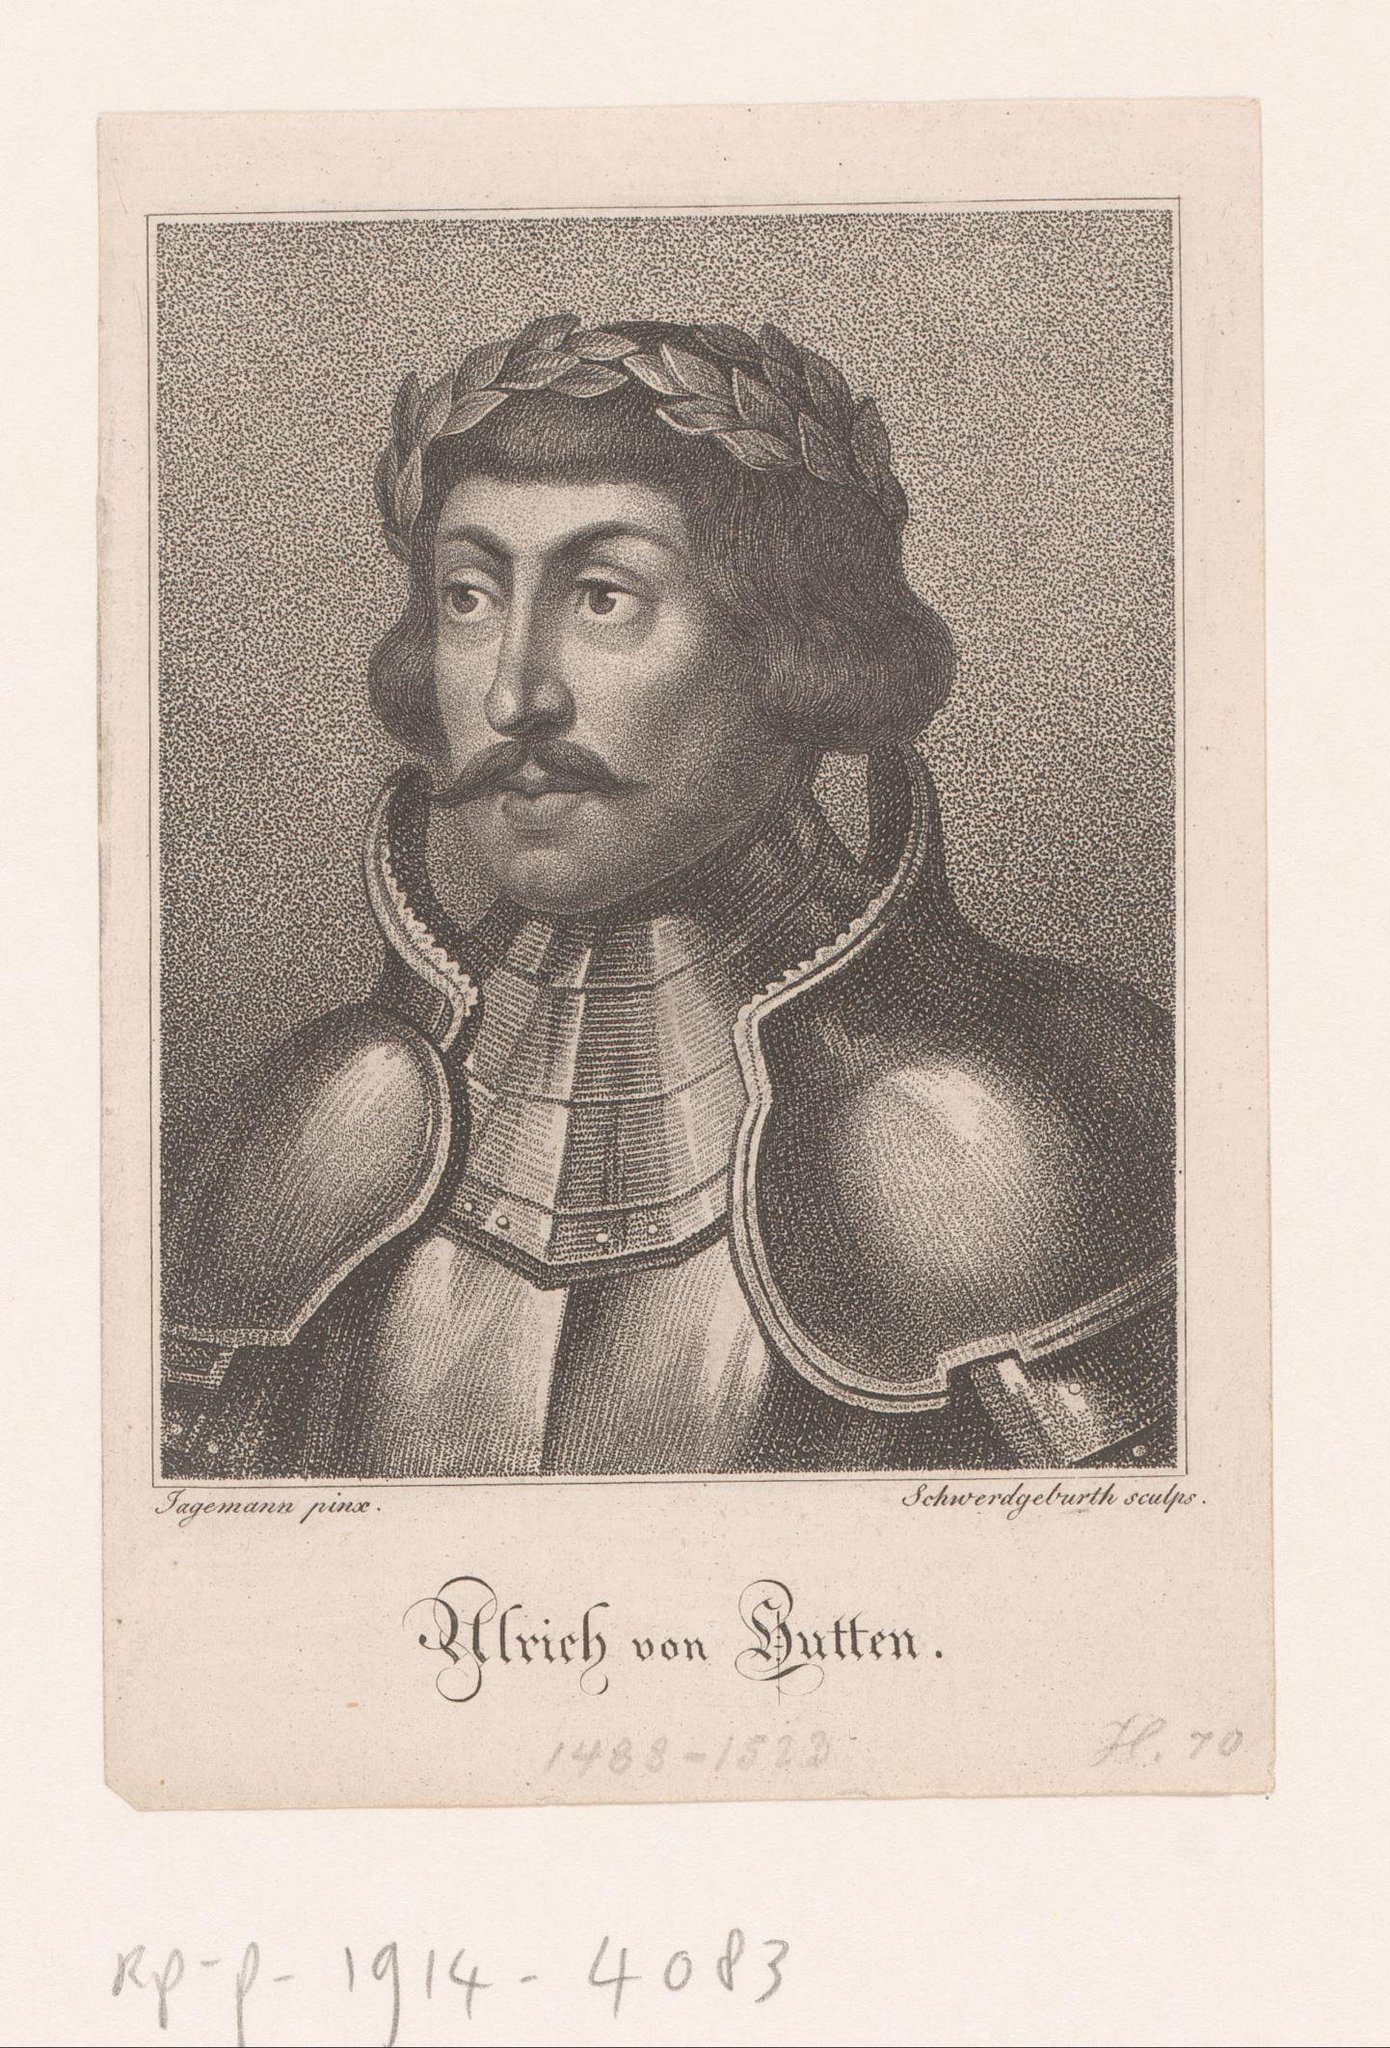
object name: print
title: Portret van Ulrich von Hutten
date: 1795-1878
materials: paper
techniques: stippling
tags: switzerland, politician, armour, historical persons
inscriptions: collector's mark: Lugt 2228